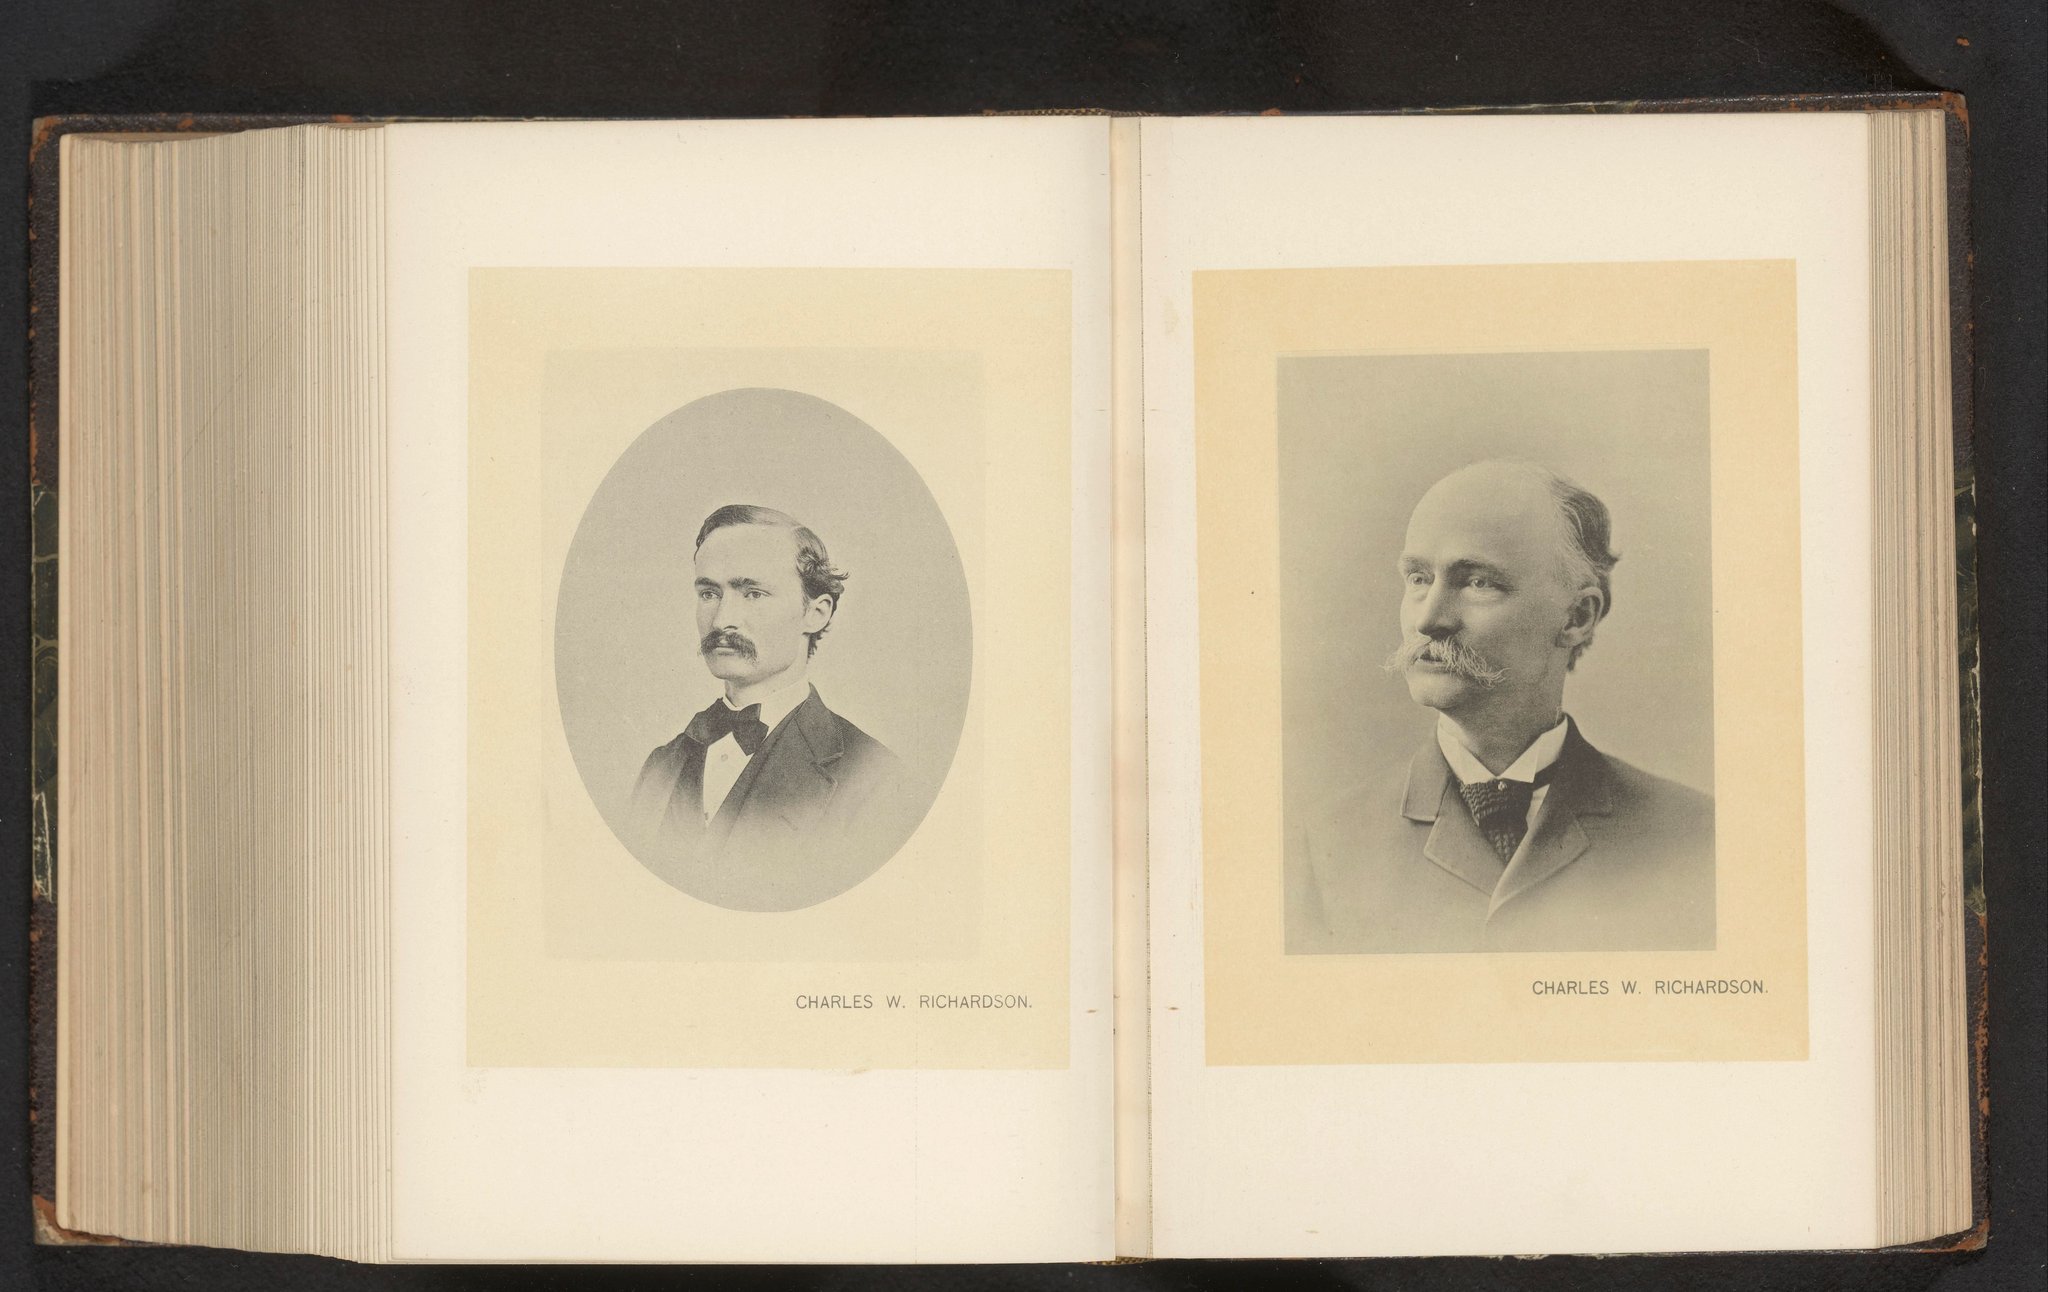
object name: page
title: Charles W. Richardson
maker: Anonymous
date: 1869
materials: paper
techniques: photoaquatint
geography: boston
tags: adult man